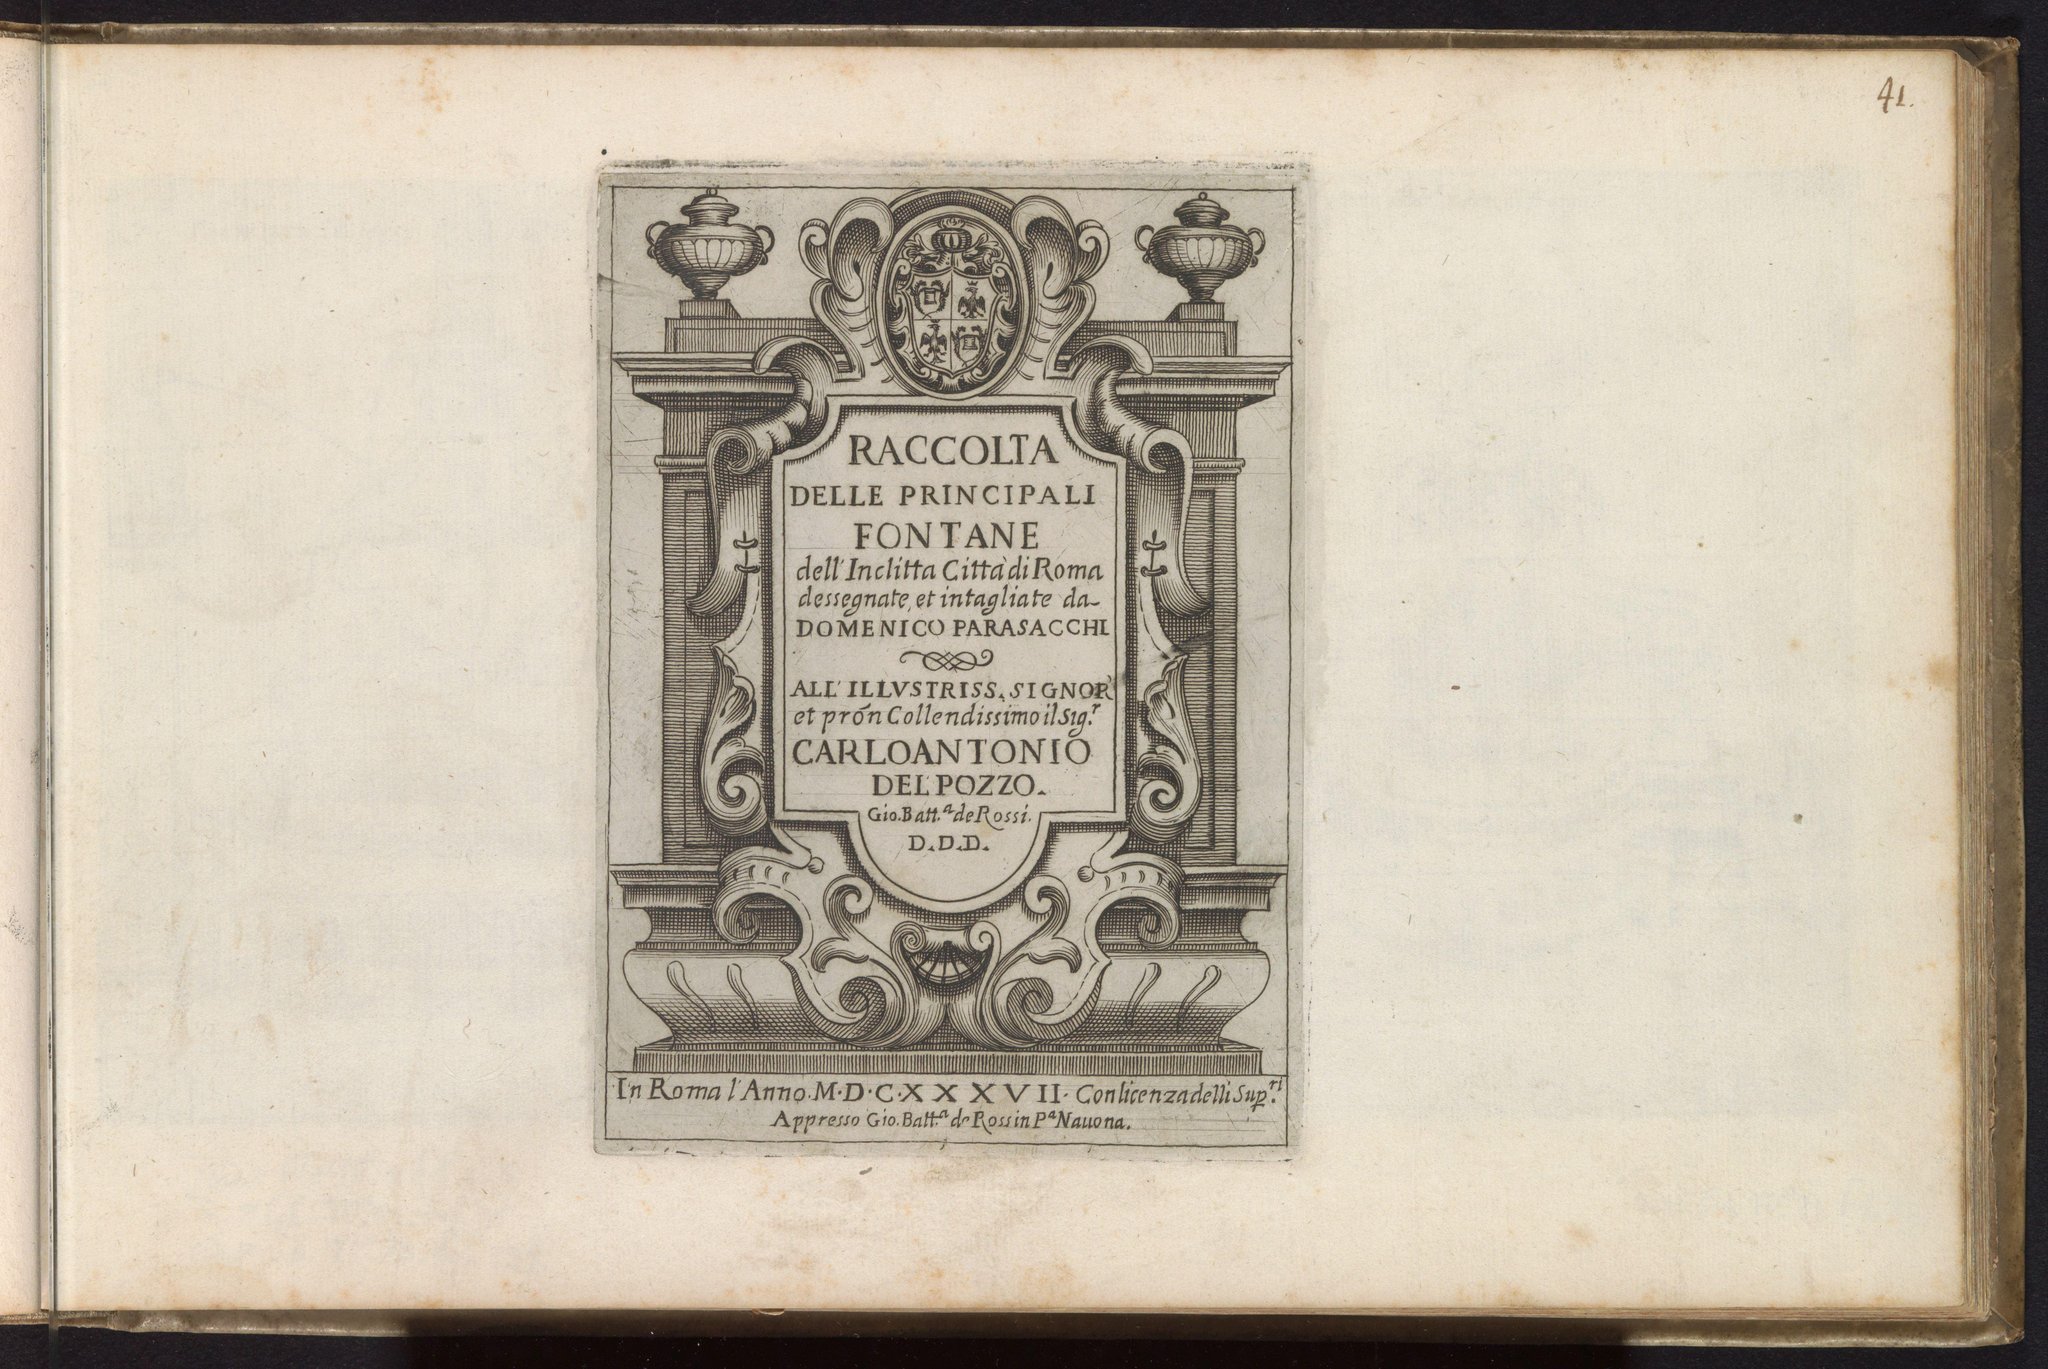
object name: titelprent, frontispice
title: Raccolta delle principali fontane dell'inclitta città di Roma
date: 1637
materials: paper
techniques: etching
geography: italy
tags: coat of arms (symbol of sovereignty), ornament ~ cartouche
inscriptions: number: ‘41’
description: Titelprent bij een reeks van ten minste 20 prenten van fonteinen in Rome.